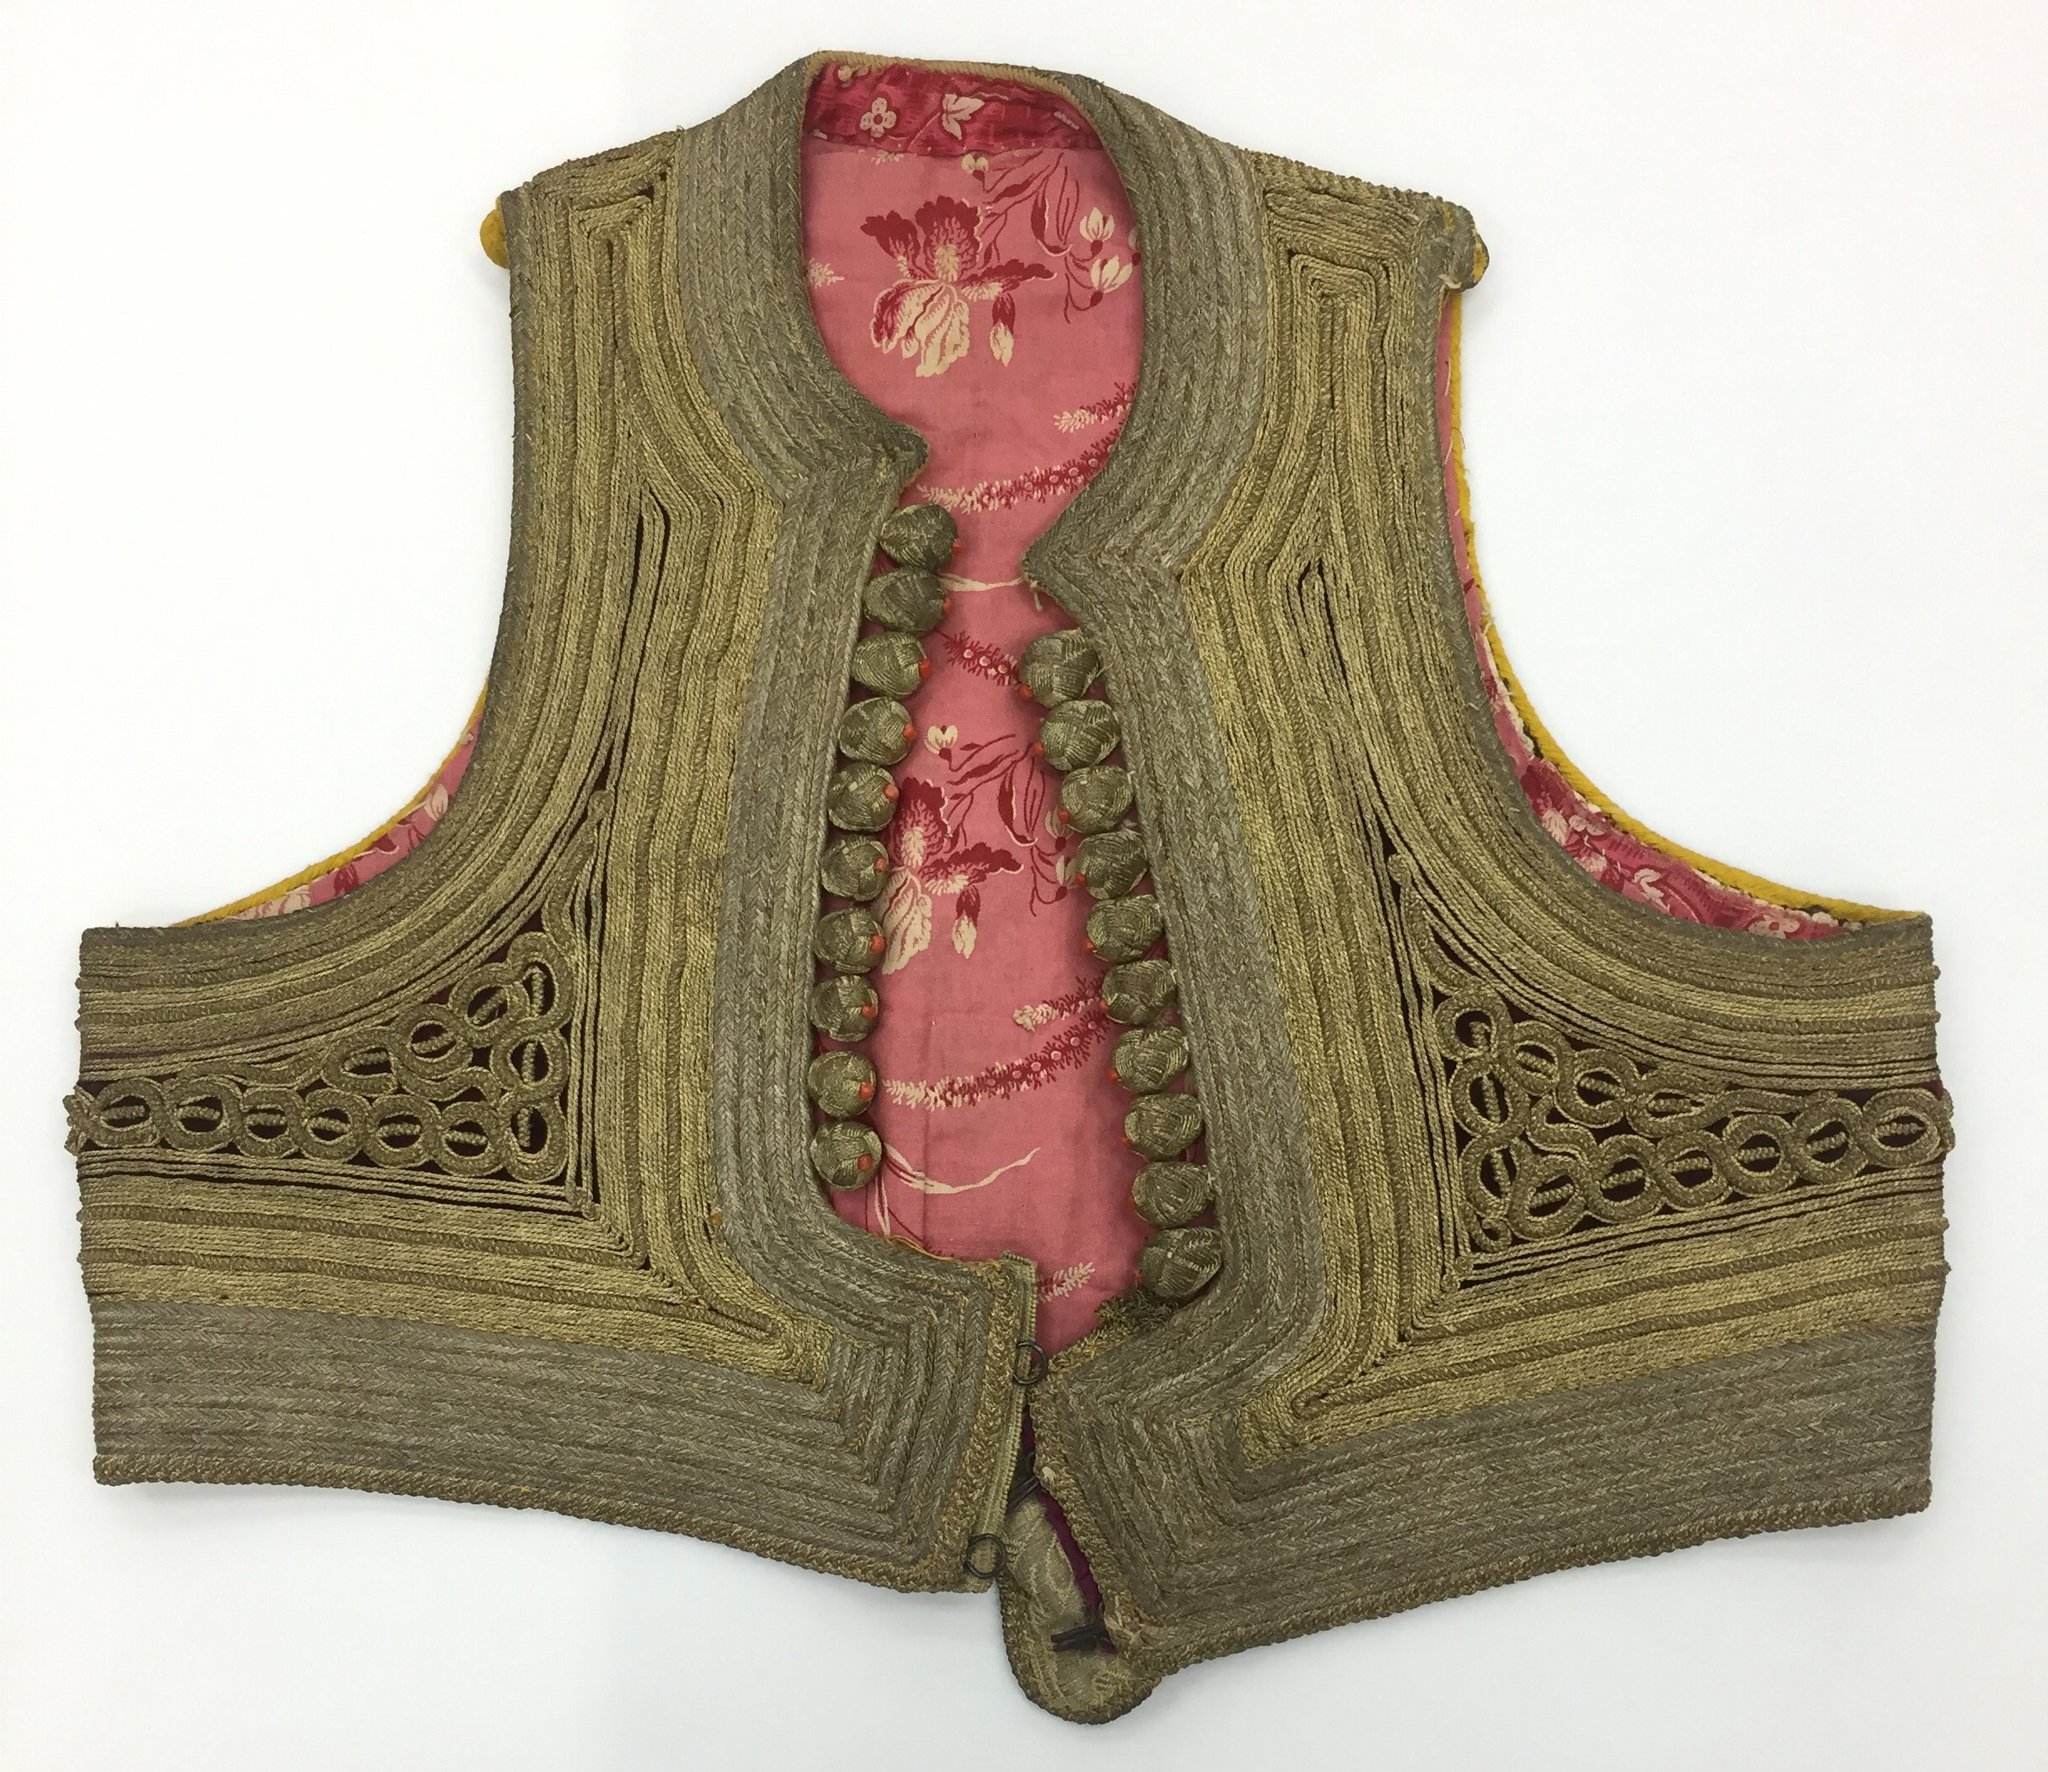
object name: vest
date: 1801-1900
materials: metal thread, velvet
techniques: embroidery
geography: turkey